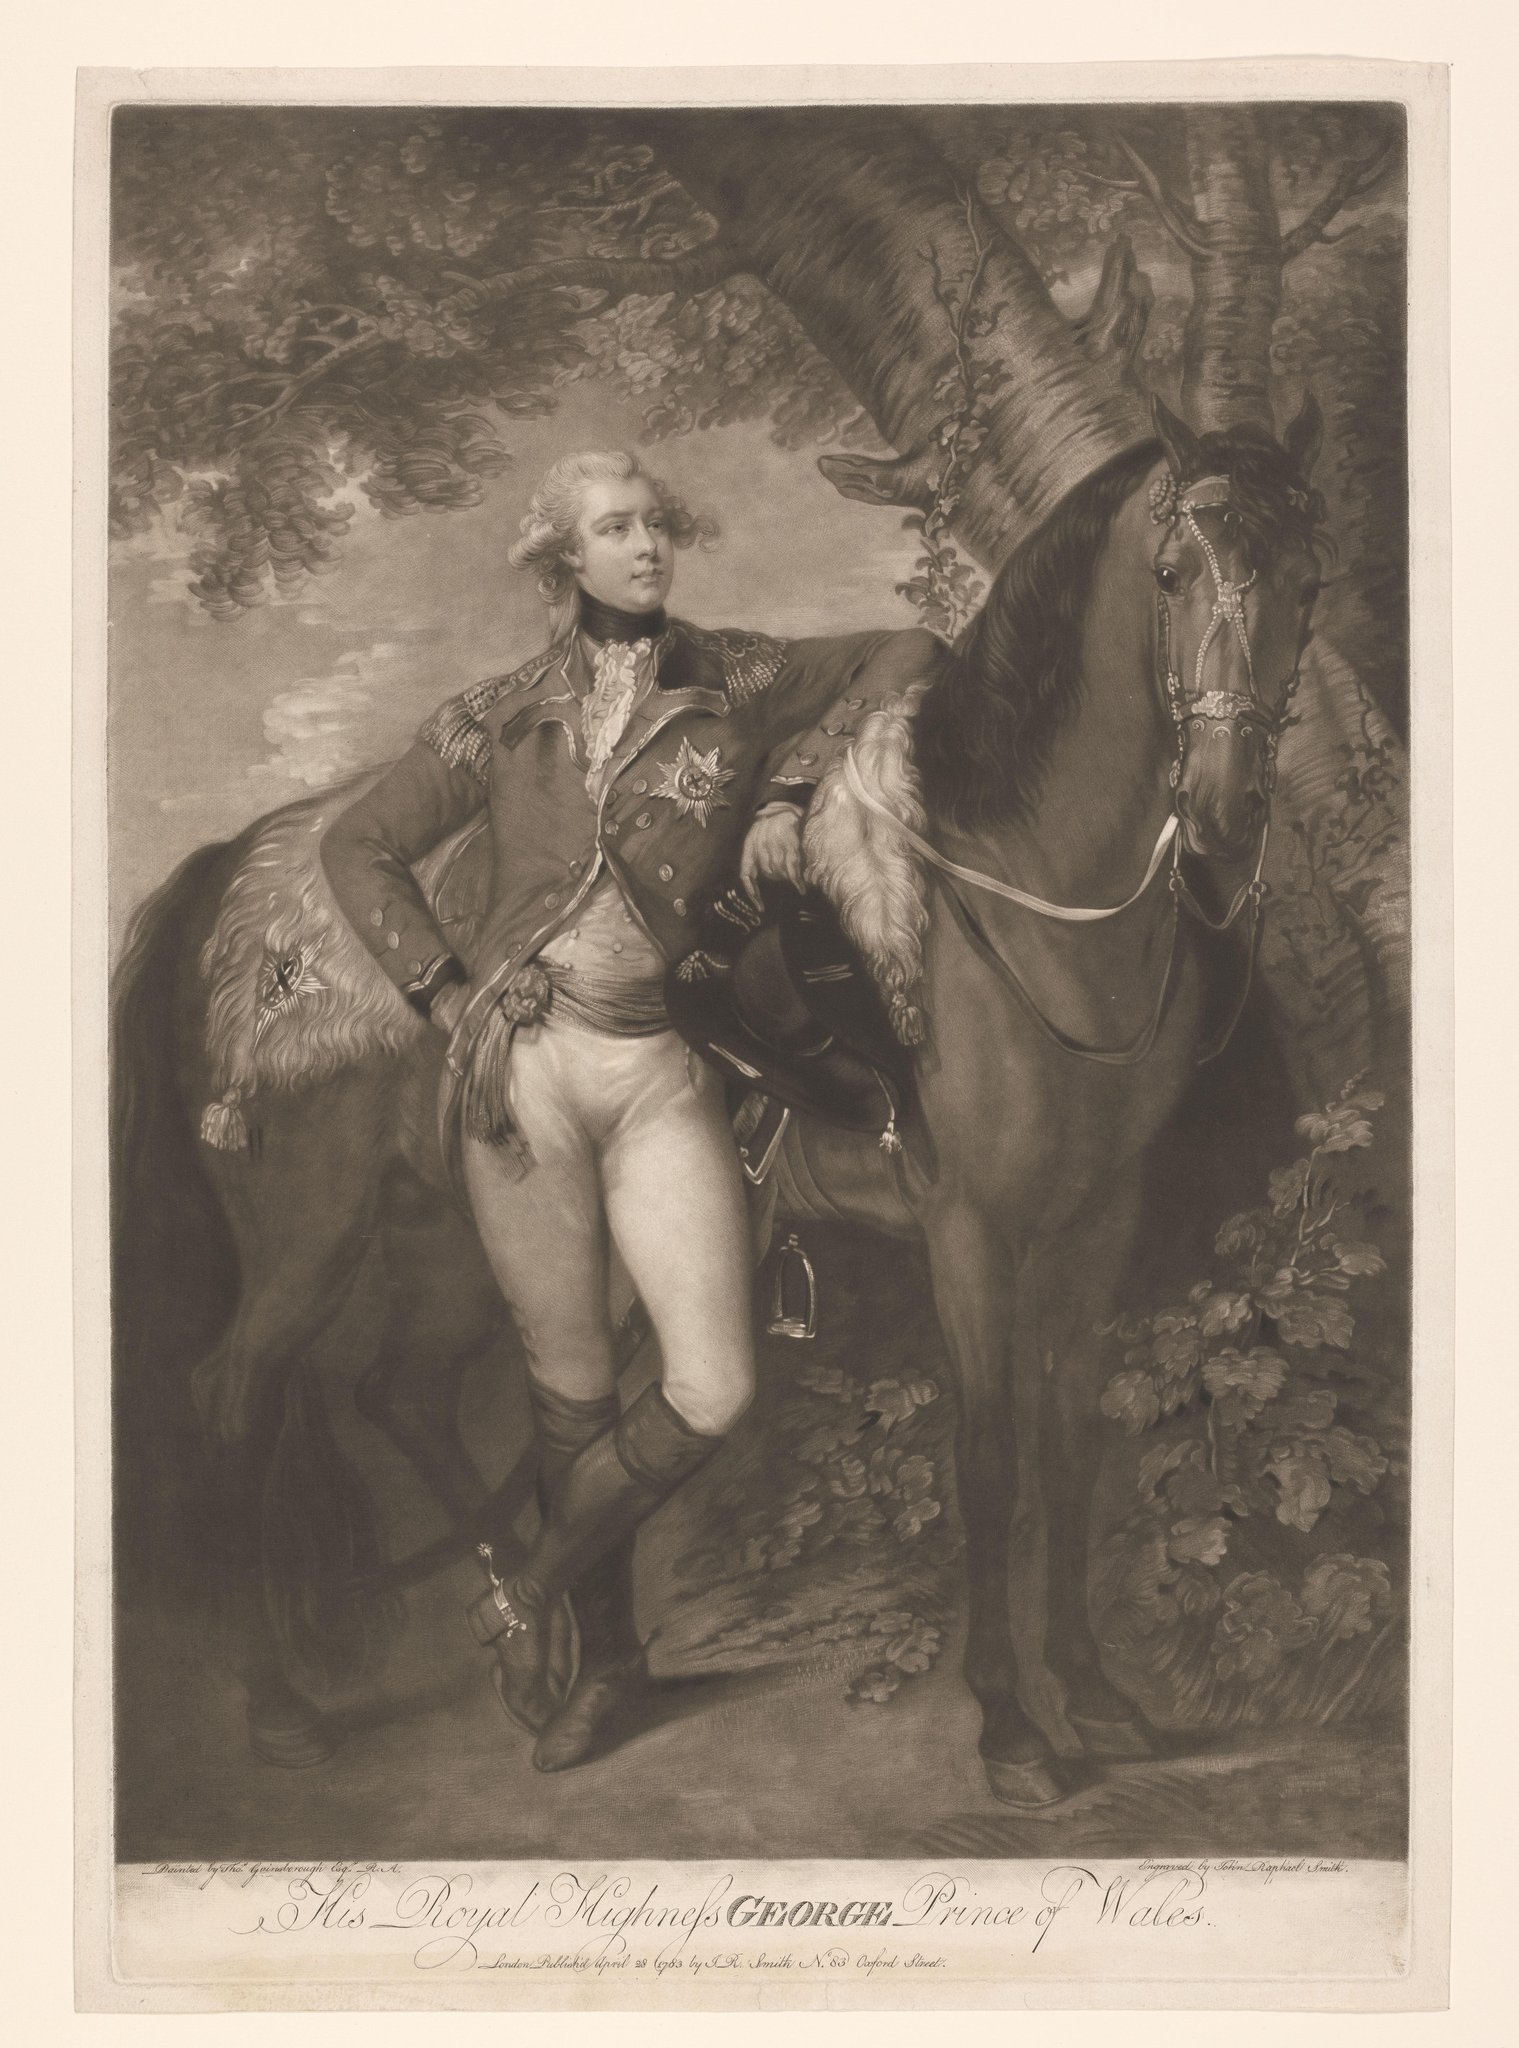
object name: print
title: Portret van George IV als prins van Wales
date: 1704-1783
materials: paper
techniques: mezzotint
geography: london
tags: george iv (koning van het verenigd koninkrijk), historical persons, horse, crown prince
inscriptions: collector's mark: Lugt 2228